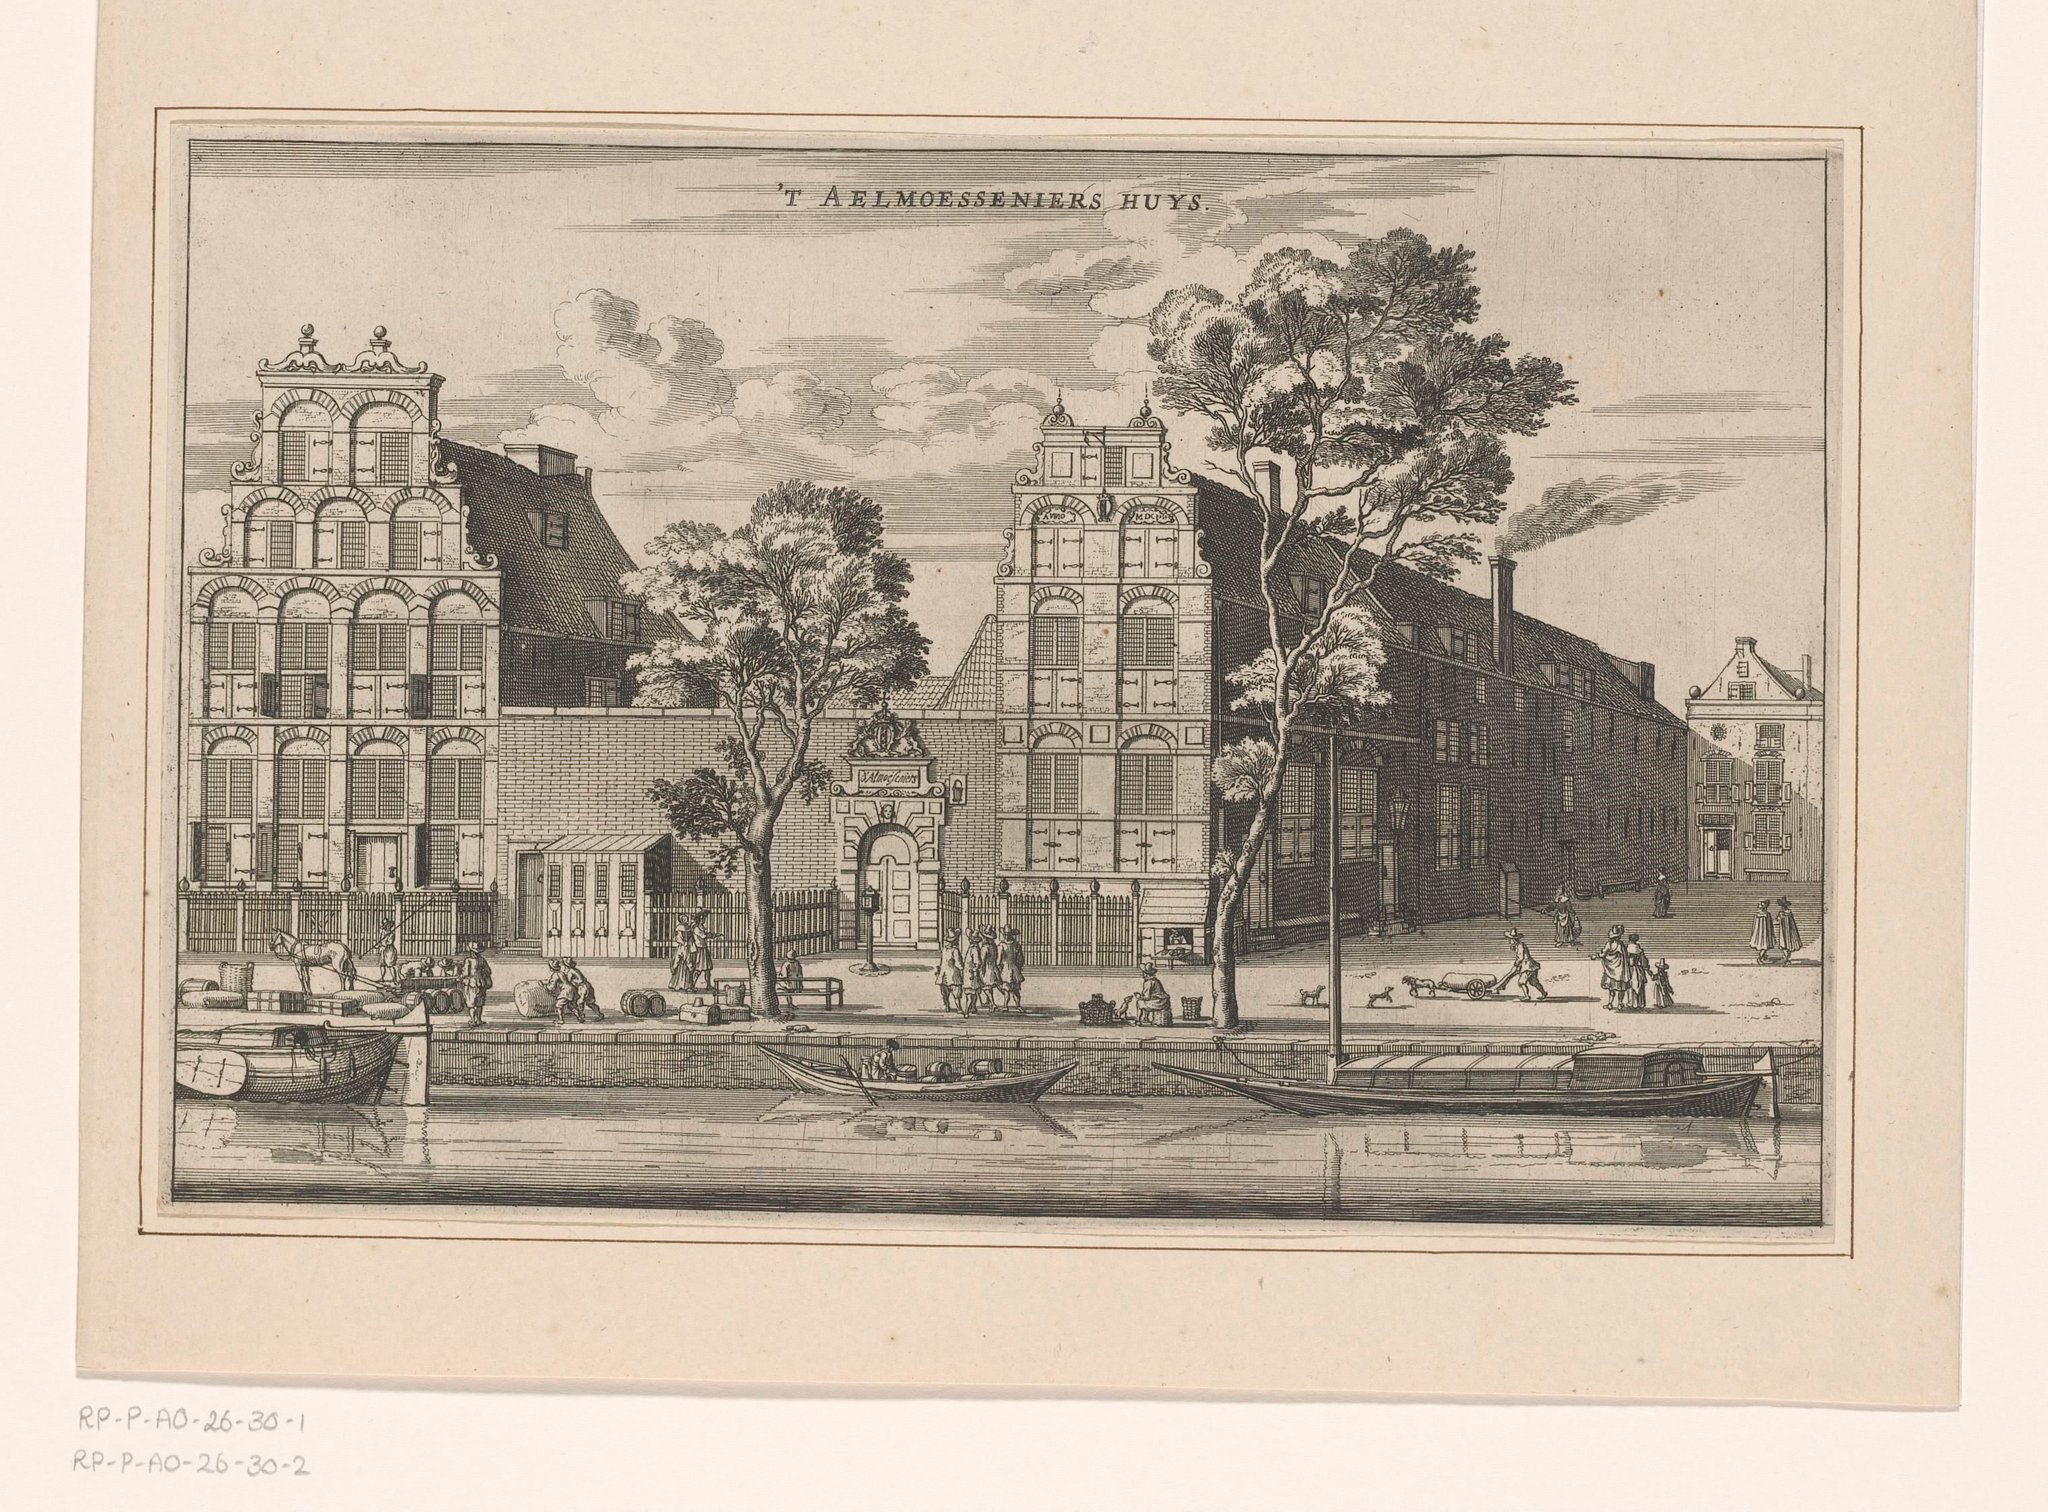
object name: print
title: 't Aelmoesseniers huys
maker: jacob van meurs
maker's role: draughtsman, print maker, publisher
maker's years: 1619-1680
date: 1663-1664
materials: paper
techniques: engraving, etching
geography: amsterdam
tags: public welfare, poorhouse, orphanage, canals, waters (in city) (+ city(-scape) with figures, staffage), street (+ city(-scape) with figures, staffage)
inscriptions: collector's mark: Lugt 195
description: Huidige staat van prent ook gebruikt in: Dapper, Olfert. Historische beschryving der stadt Amsterdam: waer in de voornaemste geschiedenissen (na een kort verhael van gansch Hollant en d'omleggende dorpen (…). Amsterdam: Jacob van Meurs, 1663.* En in: Zesen, Philipp von. Beschreibung der Stadt Amsterdam: darinnen von derselben ersten Ursprunge bis auf gegenwärtigen Zustand (…). Amsterdam: Joachim Nosche, 1664. * In sommige exemplaren van deze uitgave komt de huidige staat van de prent voor. In andere exemplaren is een latere staat ingebonden, waarop boven de Nederlandse een Franse titel is toegevoegd.